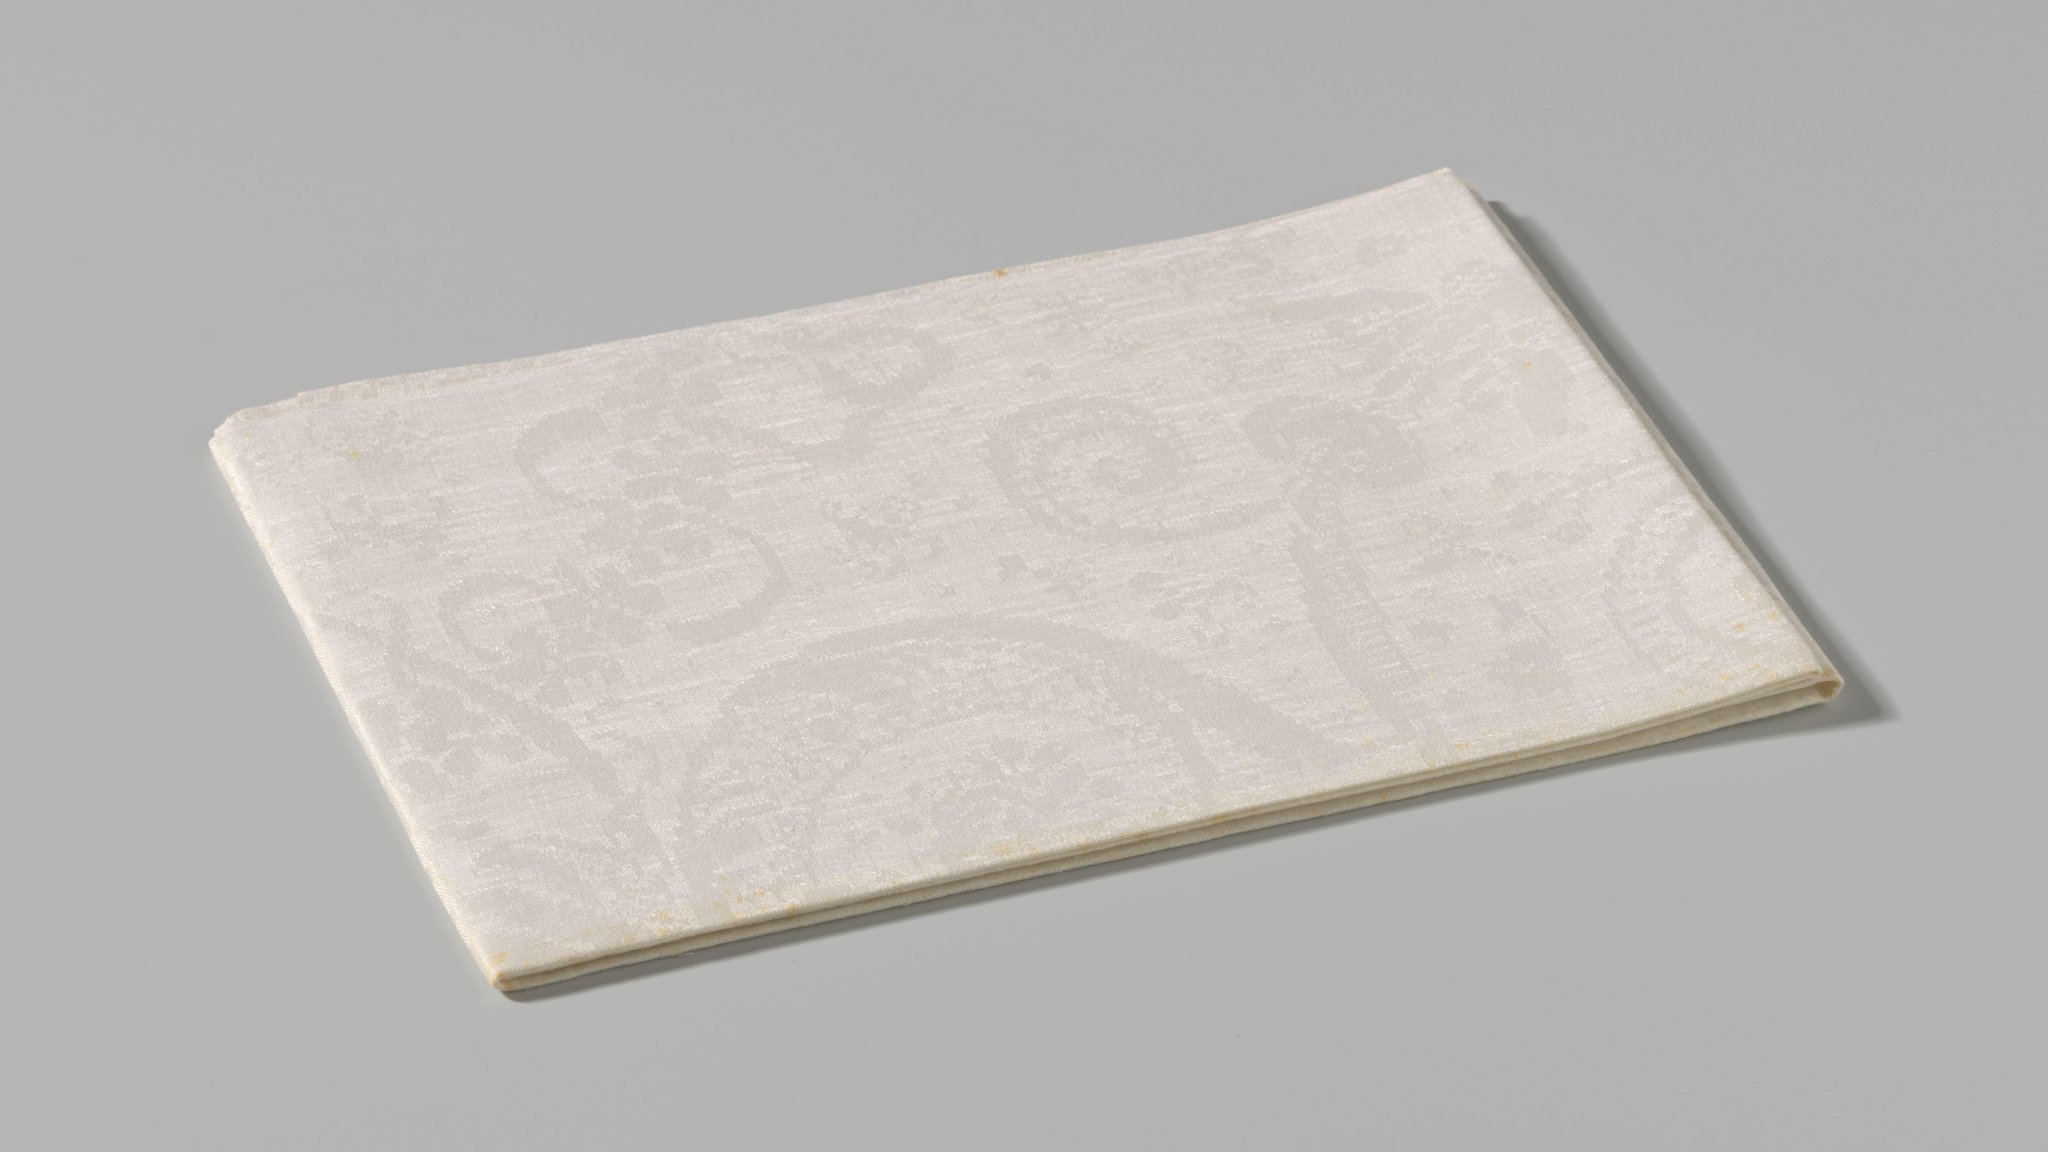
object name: napkin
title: Servet van linnendamast met een bloempatroon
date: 1680-1700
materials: linen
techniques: damask, weave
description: Servet van linnendamast met voluten en gestrooide bloemen. Het servet hoort bij zeven servetten (BK-1973-162-A t/m BK-1973-162-H) en een tafellaken (BK-1973-161).